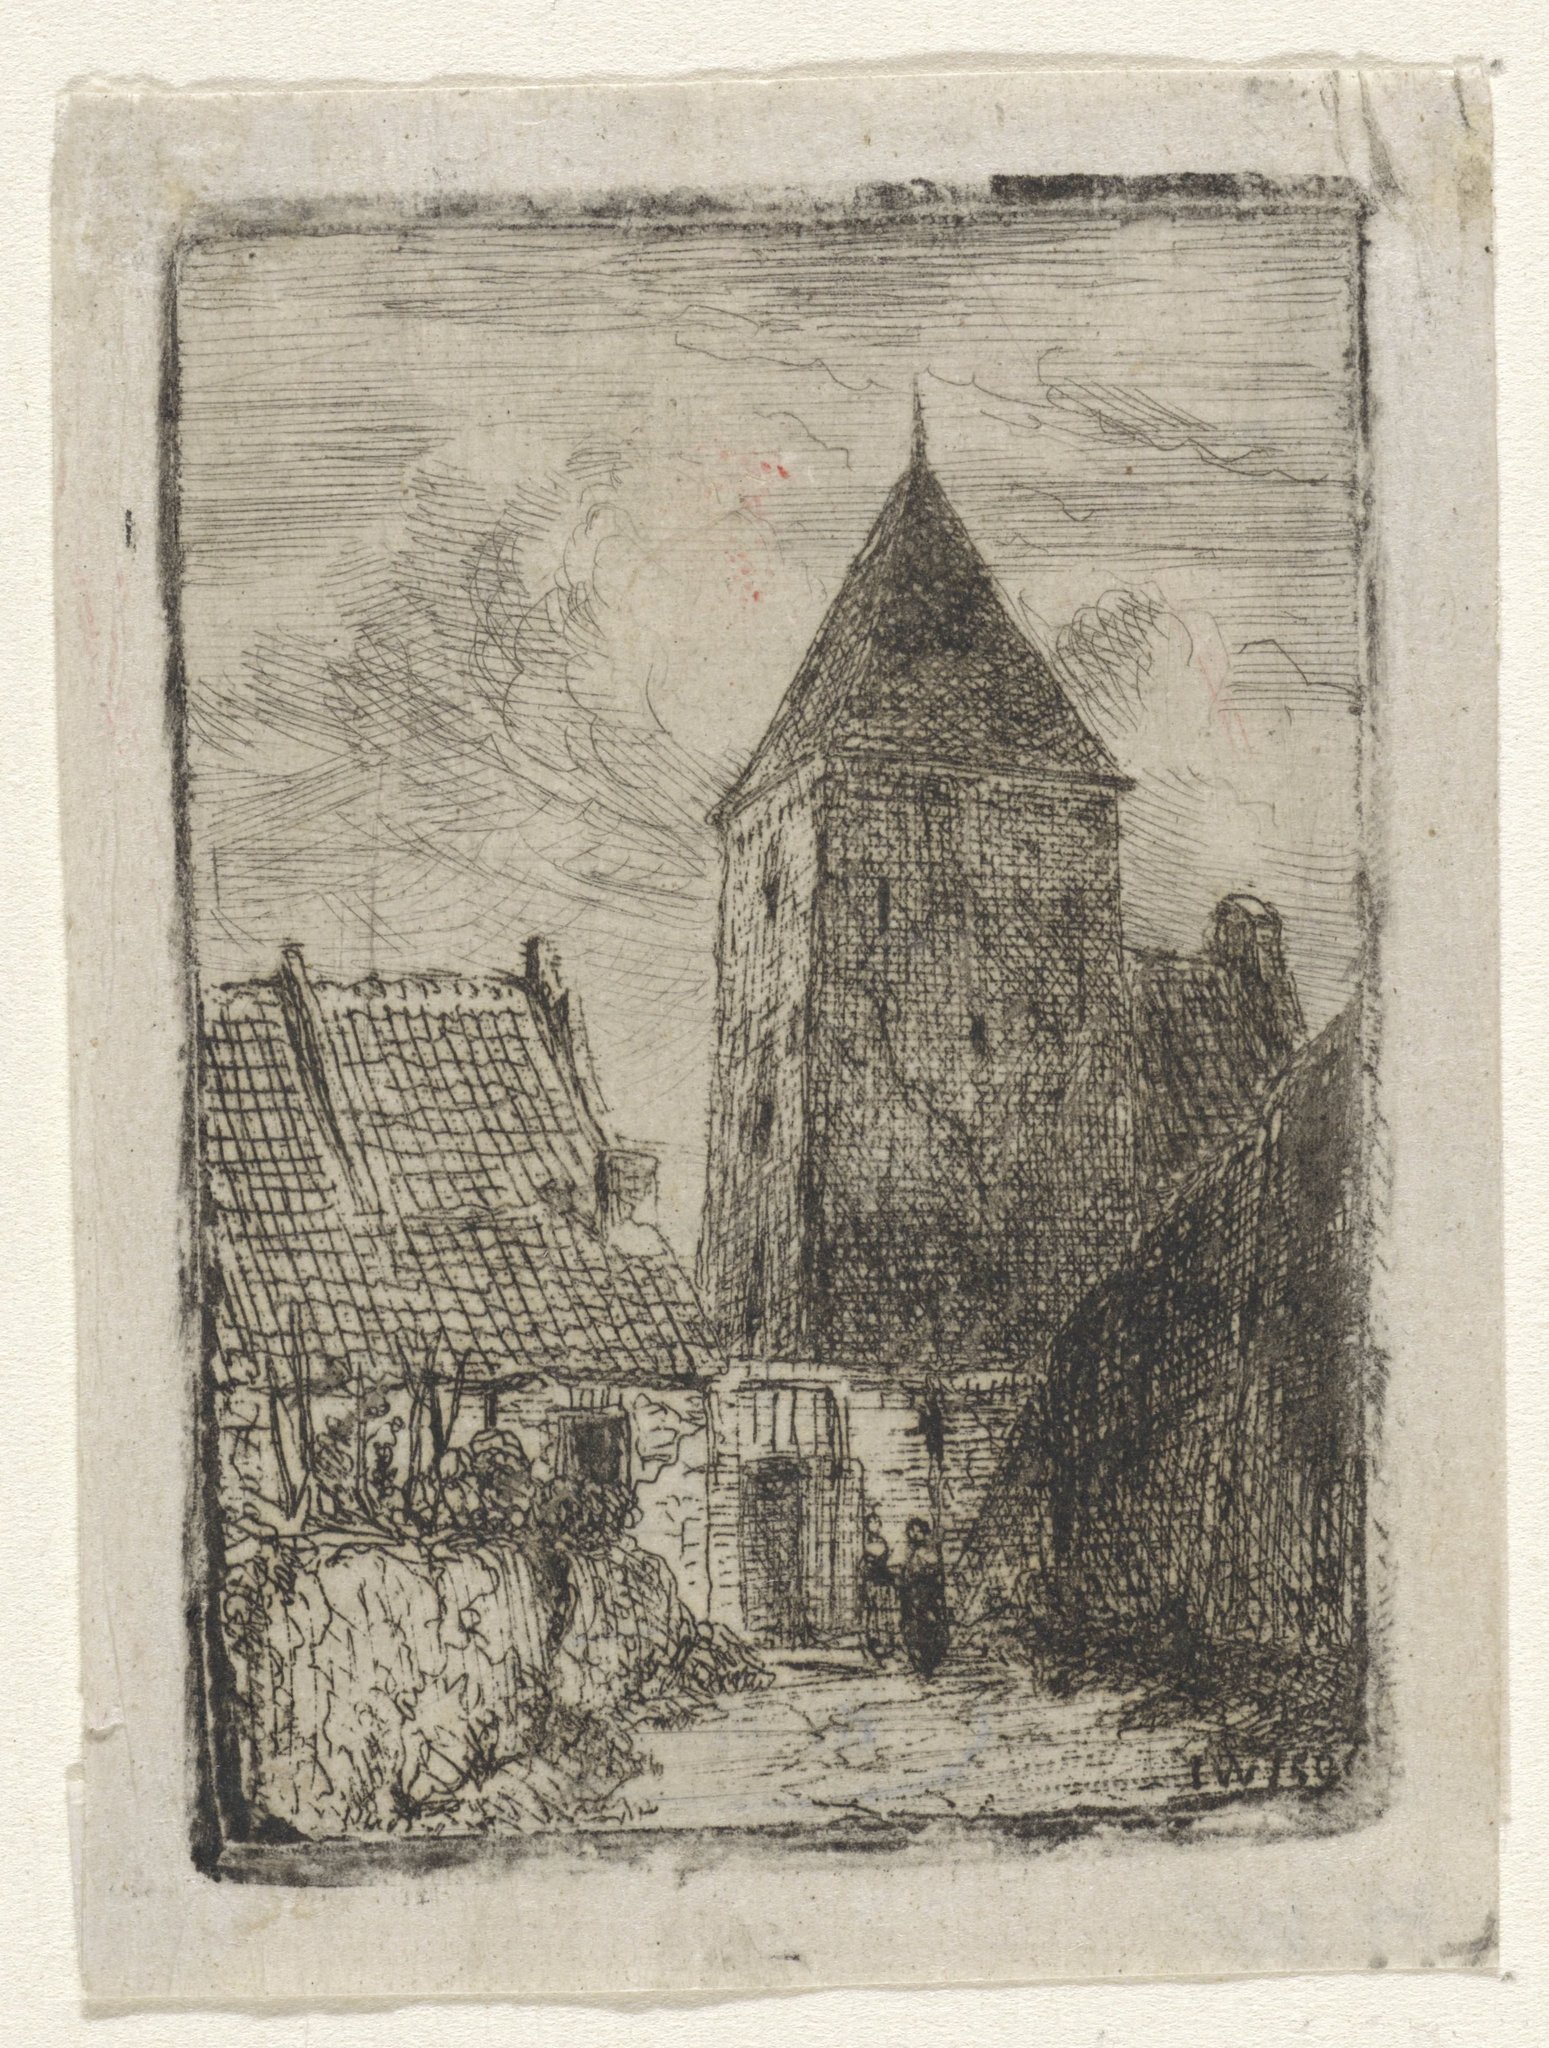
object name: print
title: Vierkante toren te Culemborg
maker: jan weissenbruch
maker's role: painter, print maker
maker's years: 1822-1880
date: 1850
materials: paper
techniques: etching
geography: culemborg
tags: urban housing, city-view, and landscape with man-made constructions, tower (of house or building)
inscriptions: date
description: Rechts staat een vierkante toren deels achter een huis. Links is nog een huis te zien. In het midden lopen twee figuren.